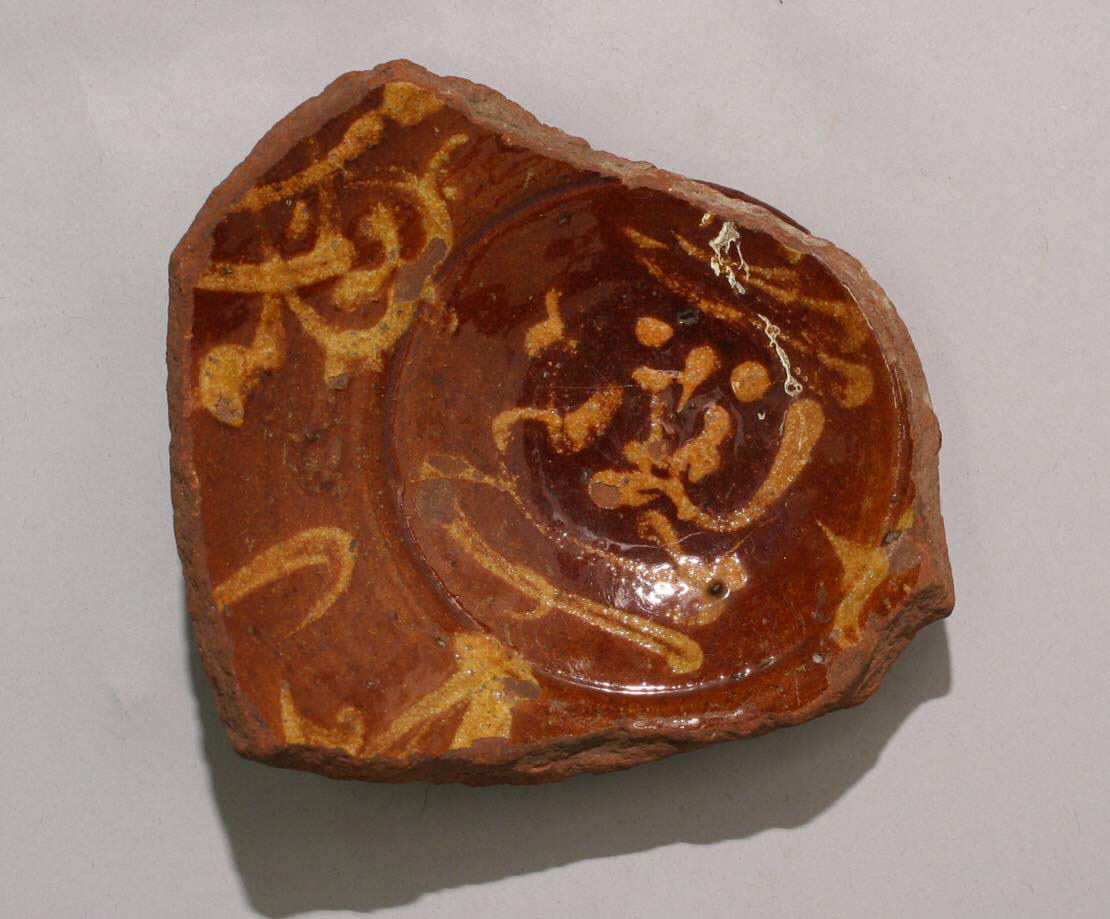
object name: fragment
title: Fragment of a Bowl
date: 1301-1500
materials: earthenware, glaze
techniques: painting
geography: egypt